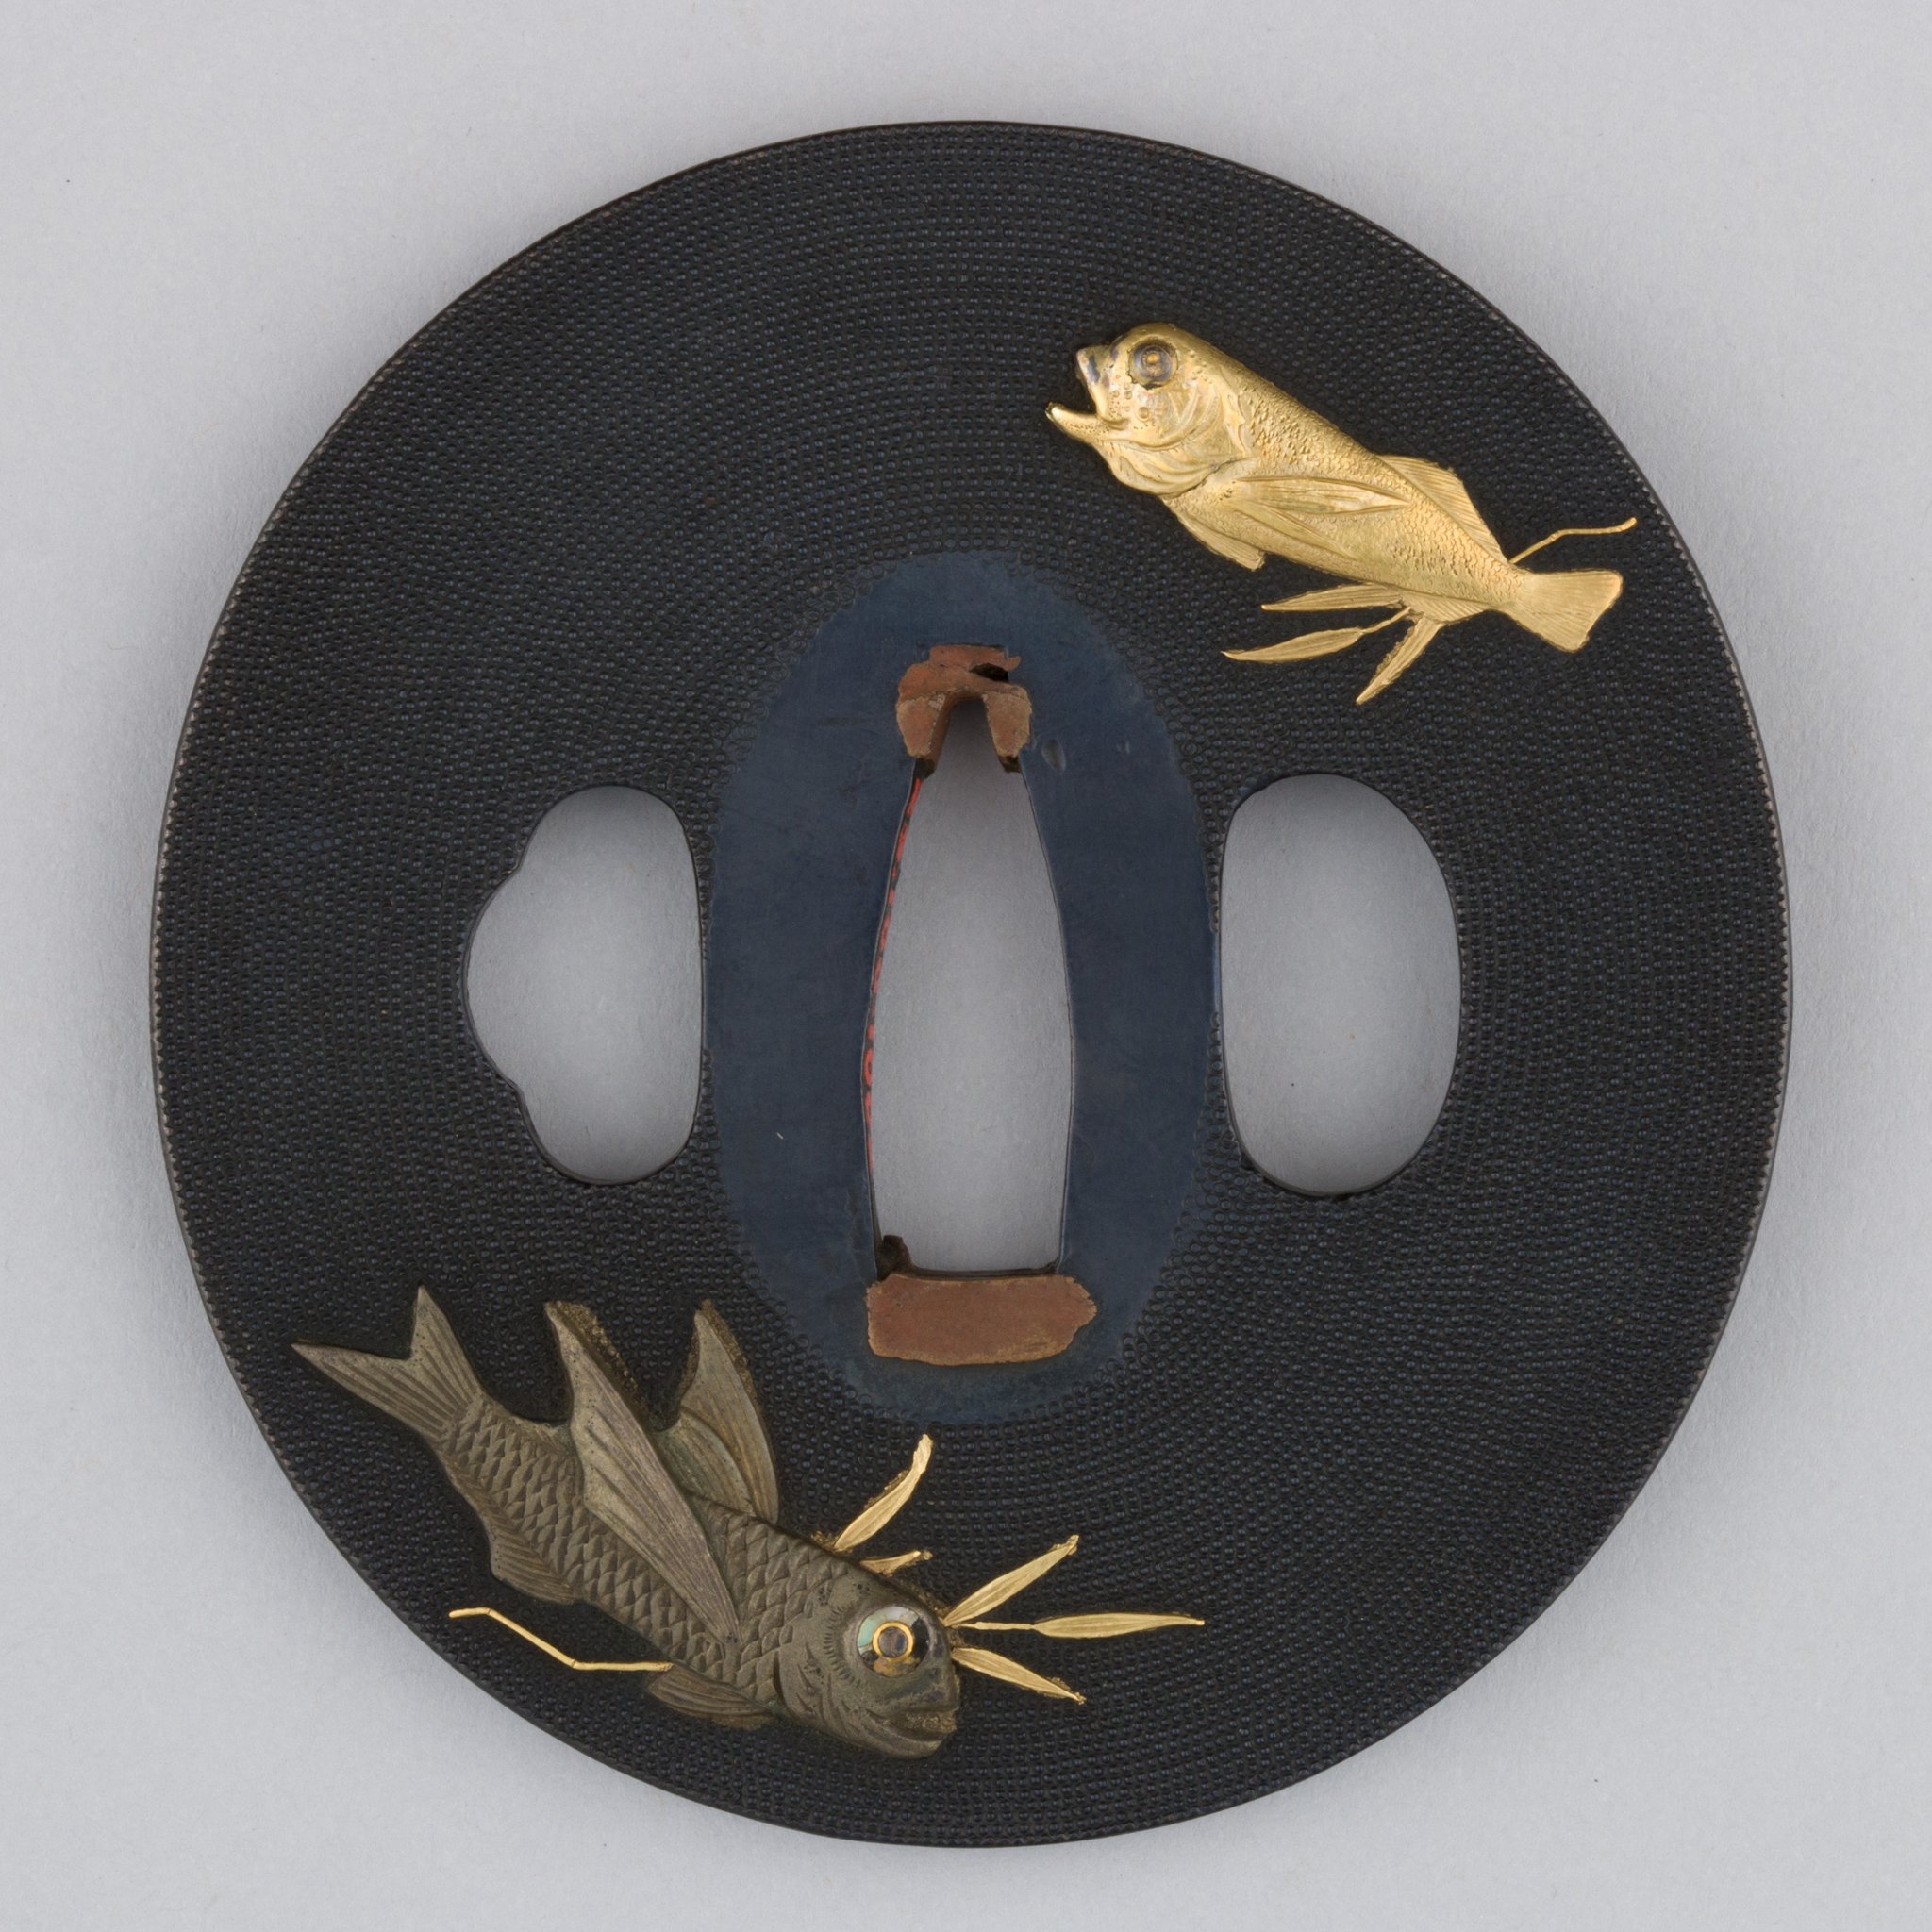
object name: sword guard tsuba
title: Sword Guard (Tsuba)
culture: japanese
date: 1615-1868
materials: copper, gold alloy, silver alloy, gold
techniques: enamel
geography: japan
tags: fish